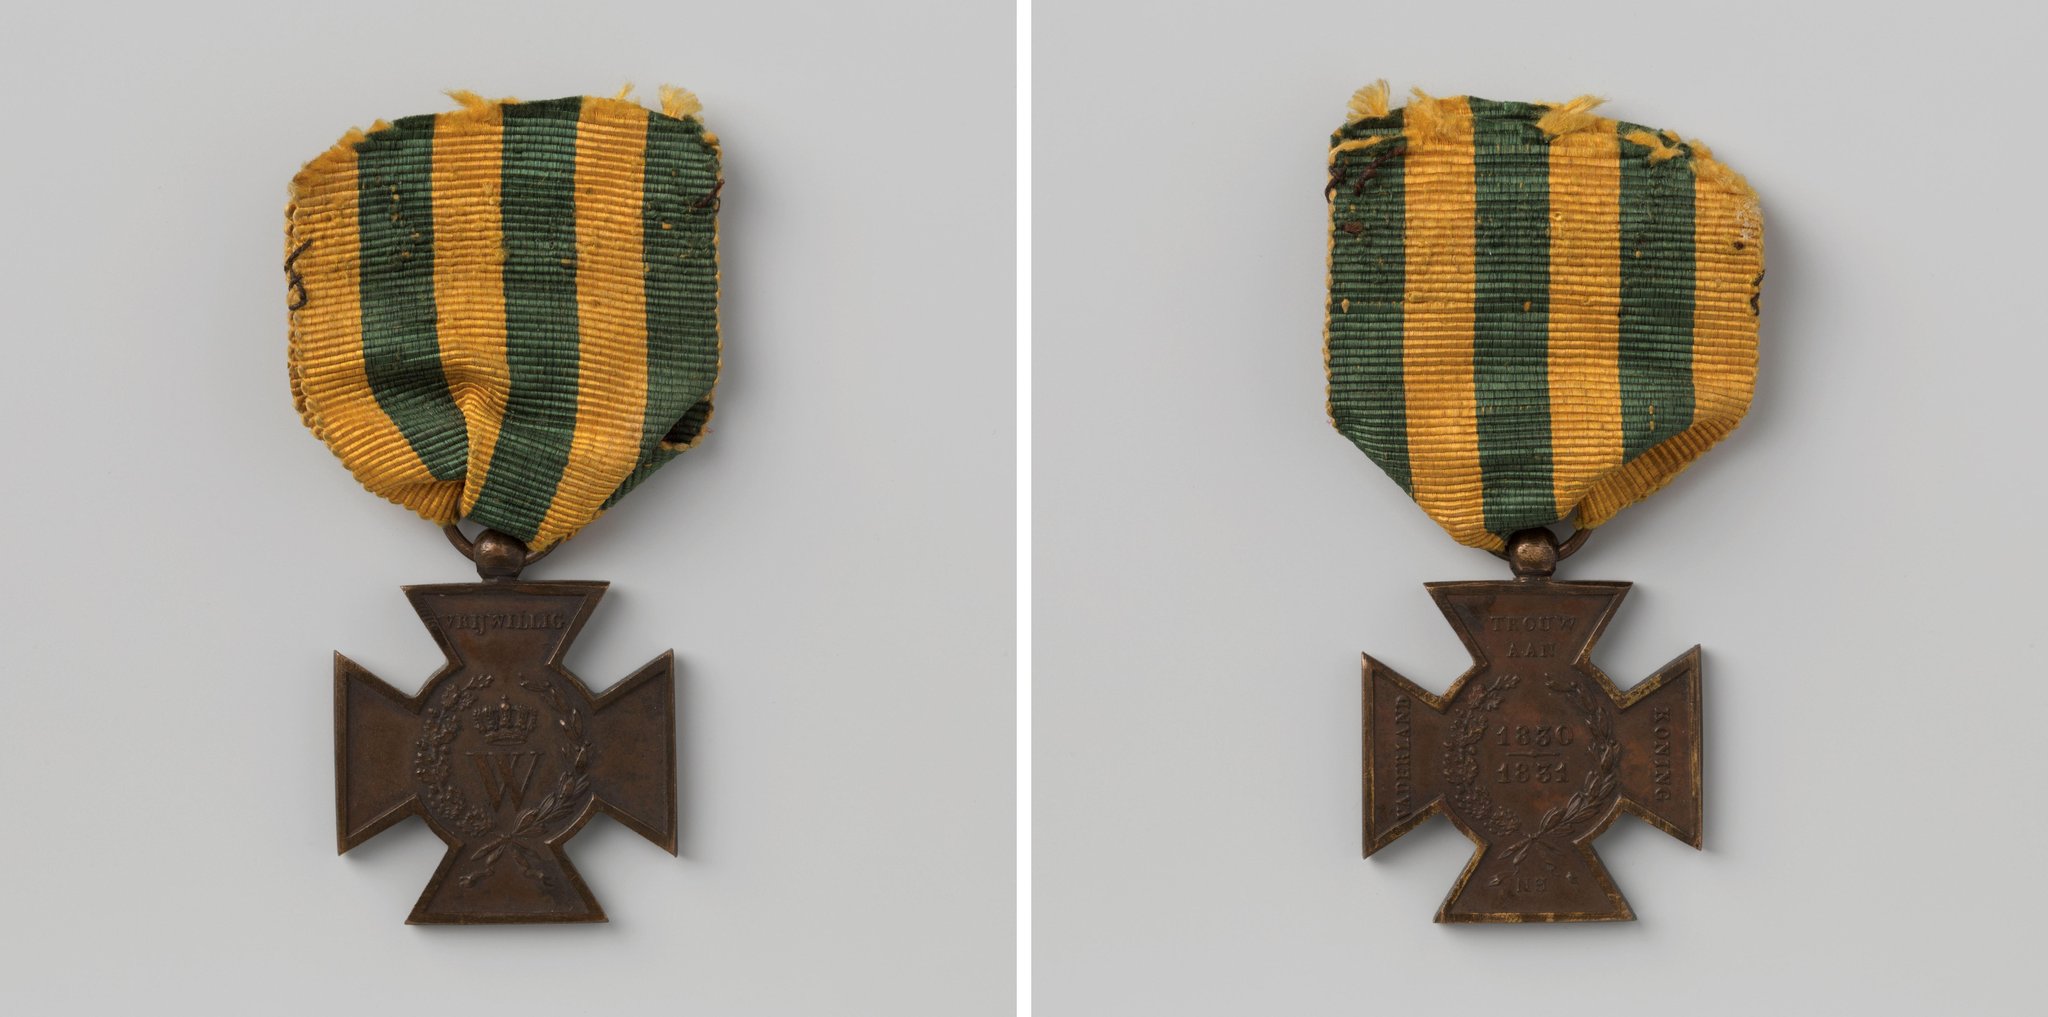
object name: draagpenning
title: Metalen Kruis voor vrijwilligers 1831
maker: david van der kellen (1804-1879)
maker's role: die cutter, draughtsman, print maker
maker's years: 1804-1879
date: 1831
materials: bronze, textile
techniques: striking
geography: utrecht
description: Bronzen kruis met bal en draagring aan een groen-geel gestreept lint, op de voorzijde een gekroonde letter W tussen samengestrikte eiken- en lauwertakken, op het bovenste been VRIJWILLIG, op de keerzijde 1830-1831 tussen samengestrikte eiken- en lauwertakken, op de benen TROUW AAN - KONING - EN - VADERLAND